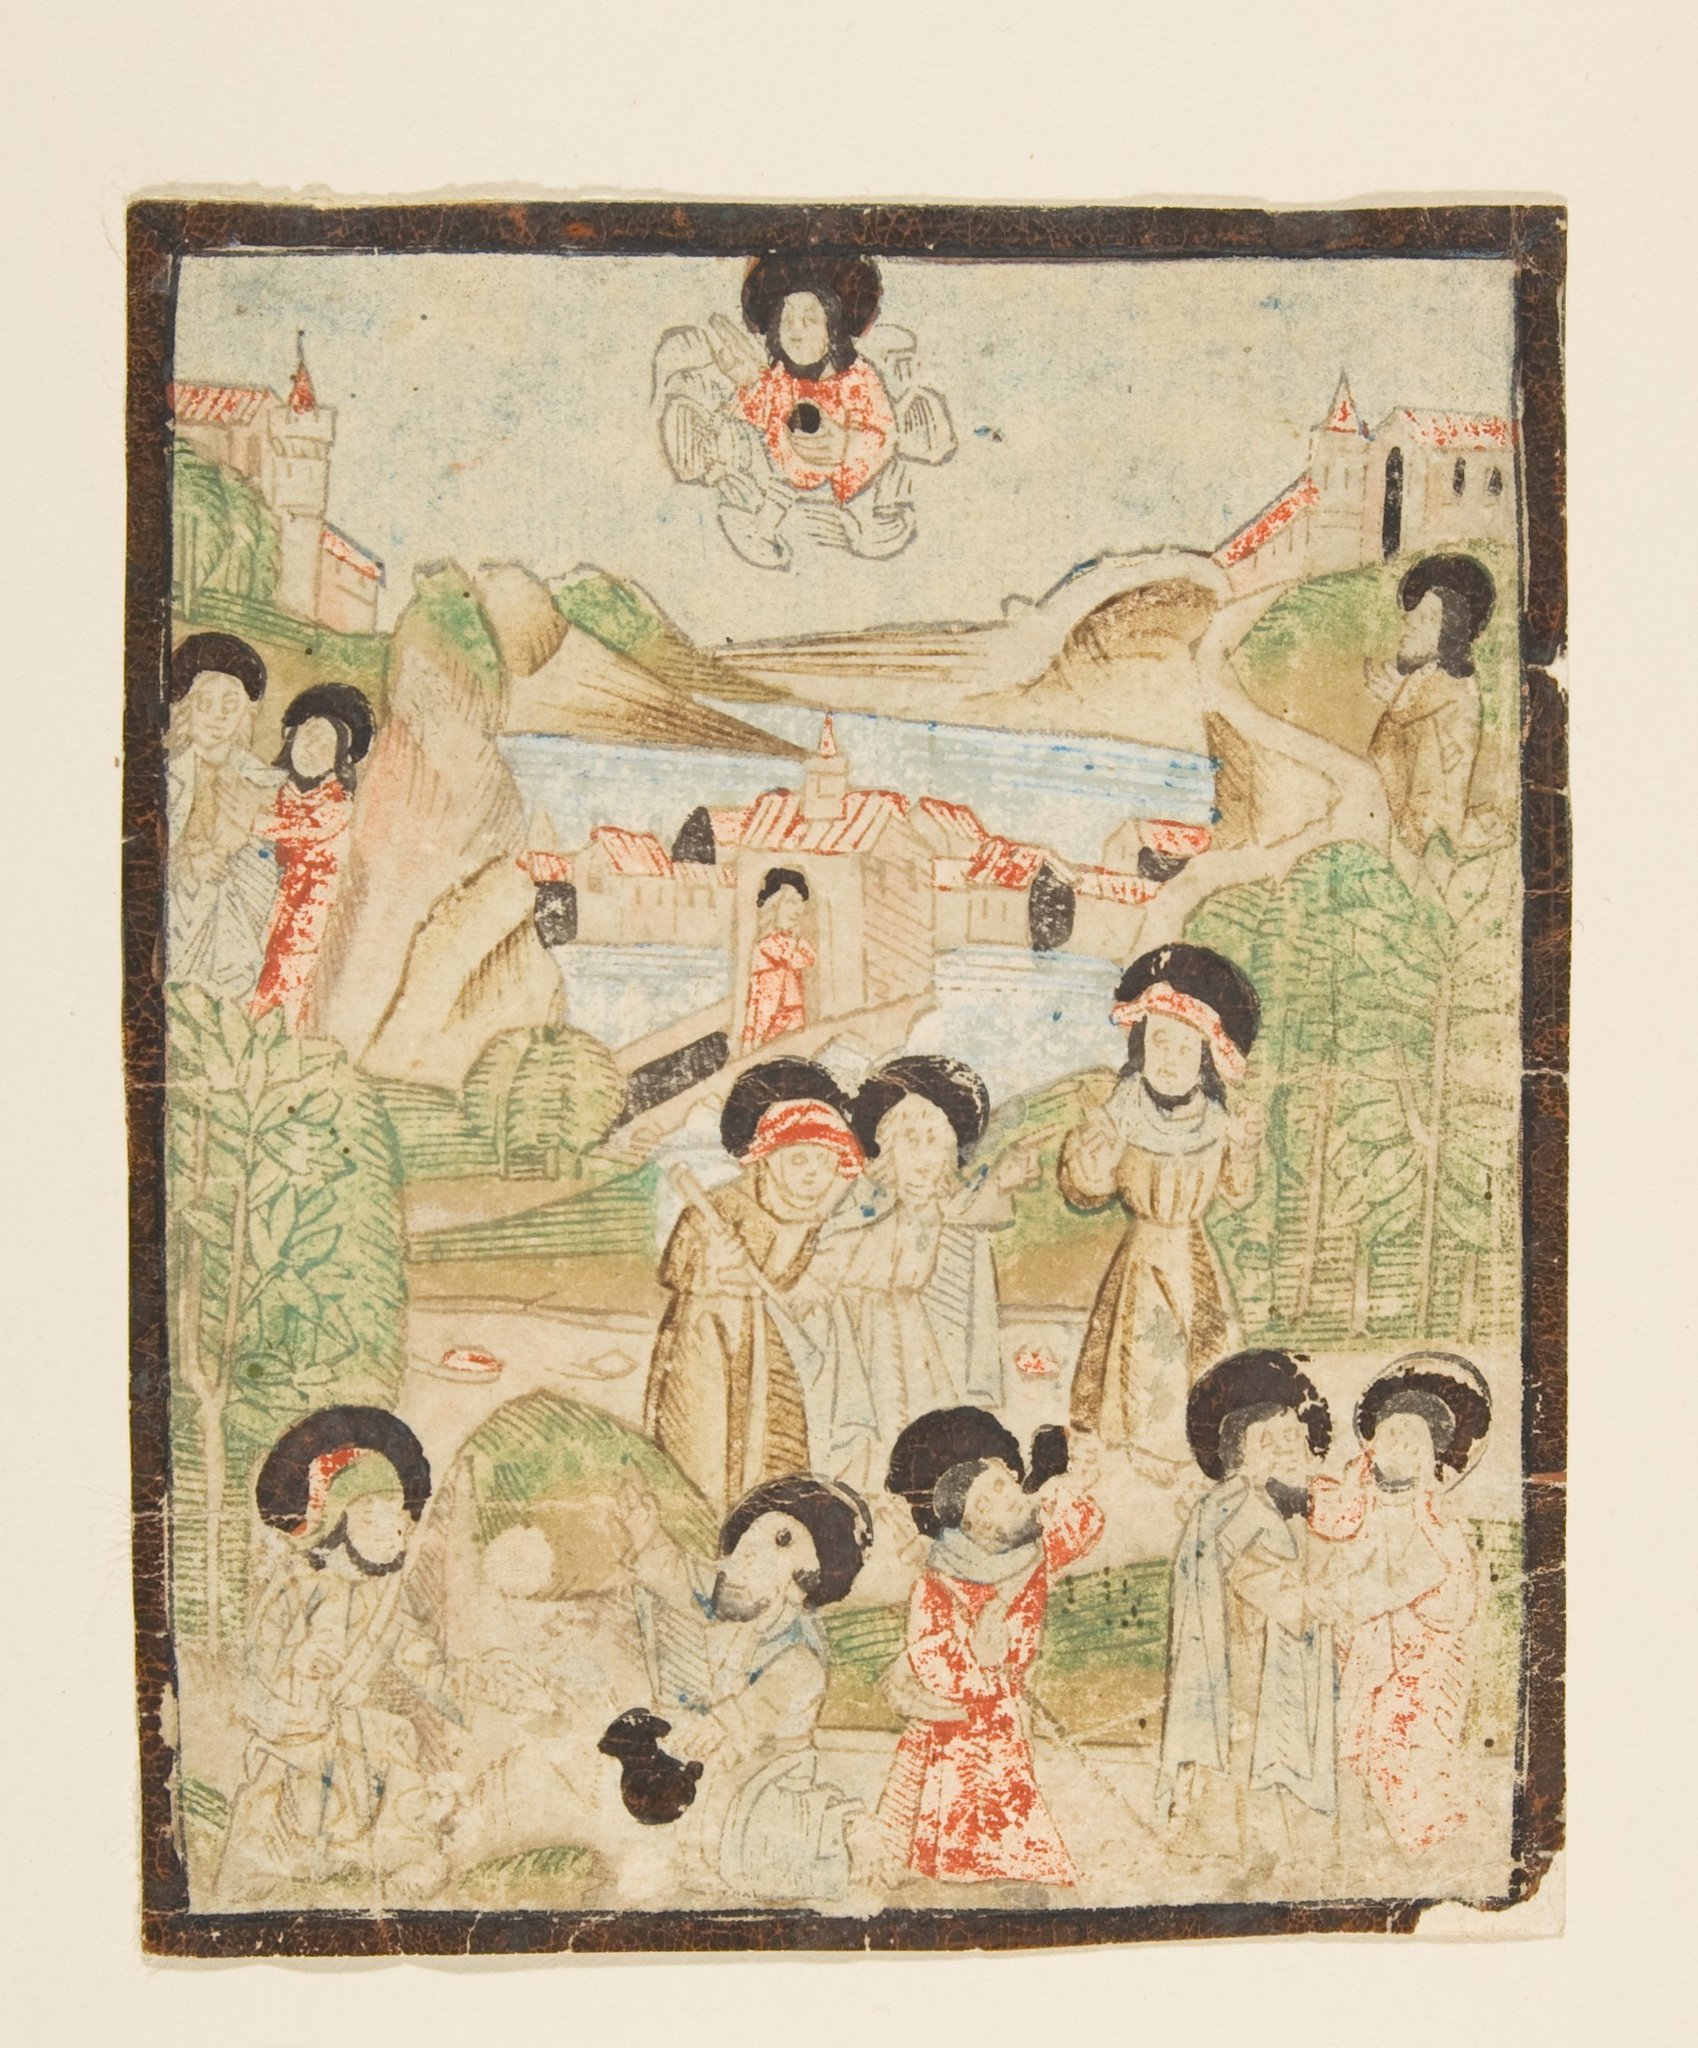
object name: print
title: Hermit Saints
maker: anonymous, german, 15th century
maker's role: artist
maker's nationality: german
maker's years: 1400-1500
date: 1401-1500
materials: silver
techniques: hand coloring, printing, woodcut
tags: men,saints